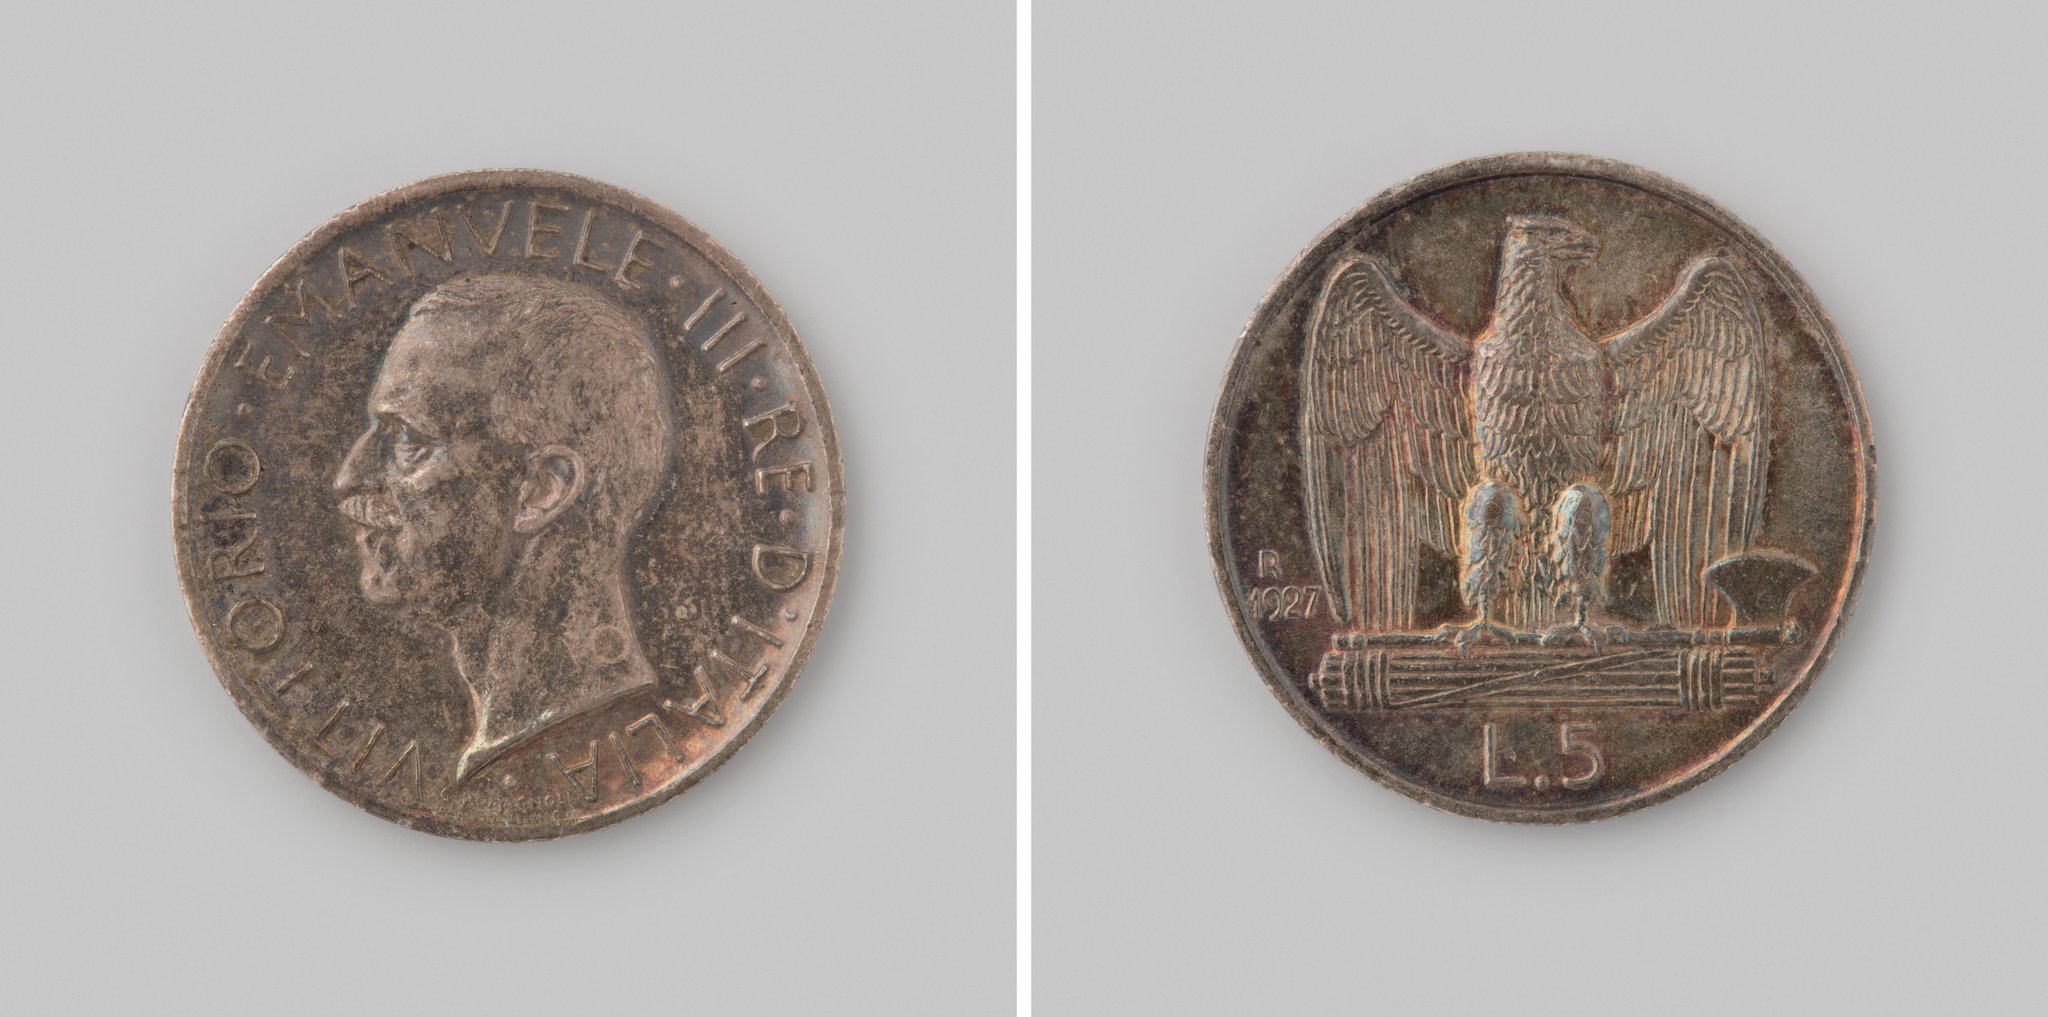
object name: coin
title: 5 lire uit Italië van koning Vittorio Emanuele III, 1927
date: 1927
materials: silver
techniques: striking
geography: rome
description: Zilveren munt. Voorzijde: hoofd van de koning naar links. Keerzijde: op pijlenbundel met bijl gezeten adelaar met gepreide vleugels. links daarvan jaartal, waarboven muntteken: letter R [=Rome]. Waarde-aanduiding in afsnede. Gladde rand.